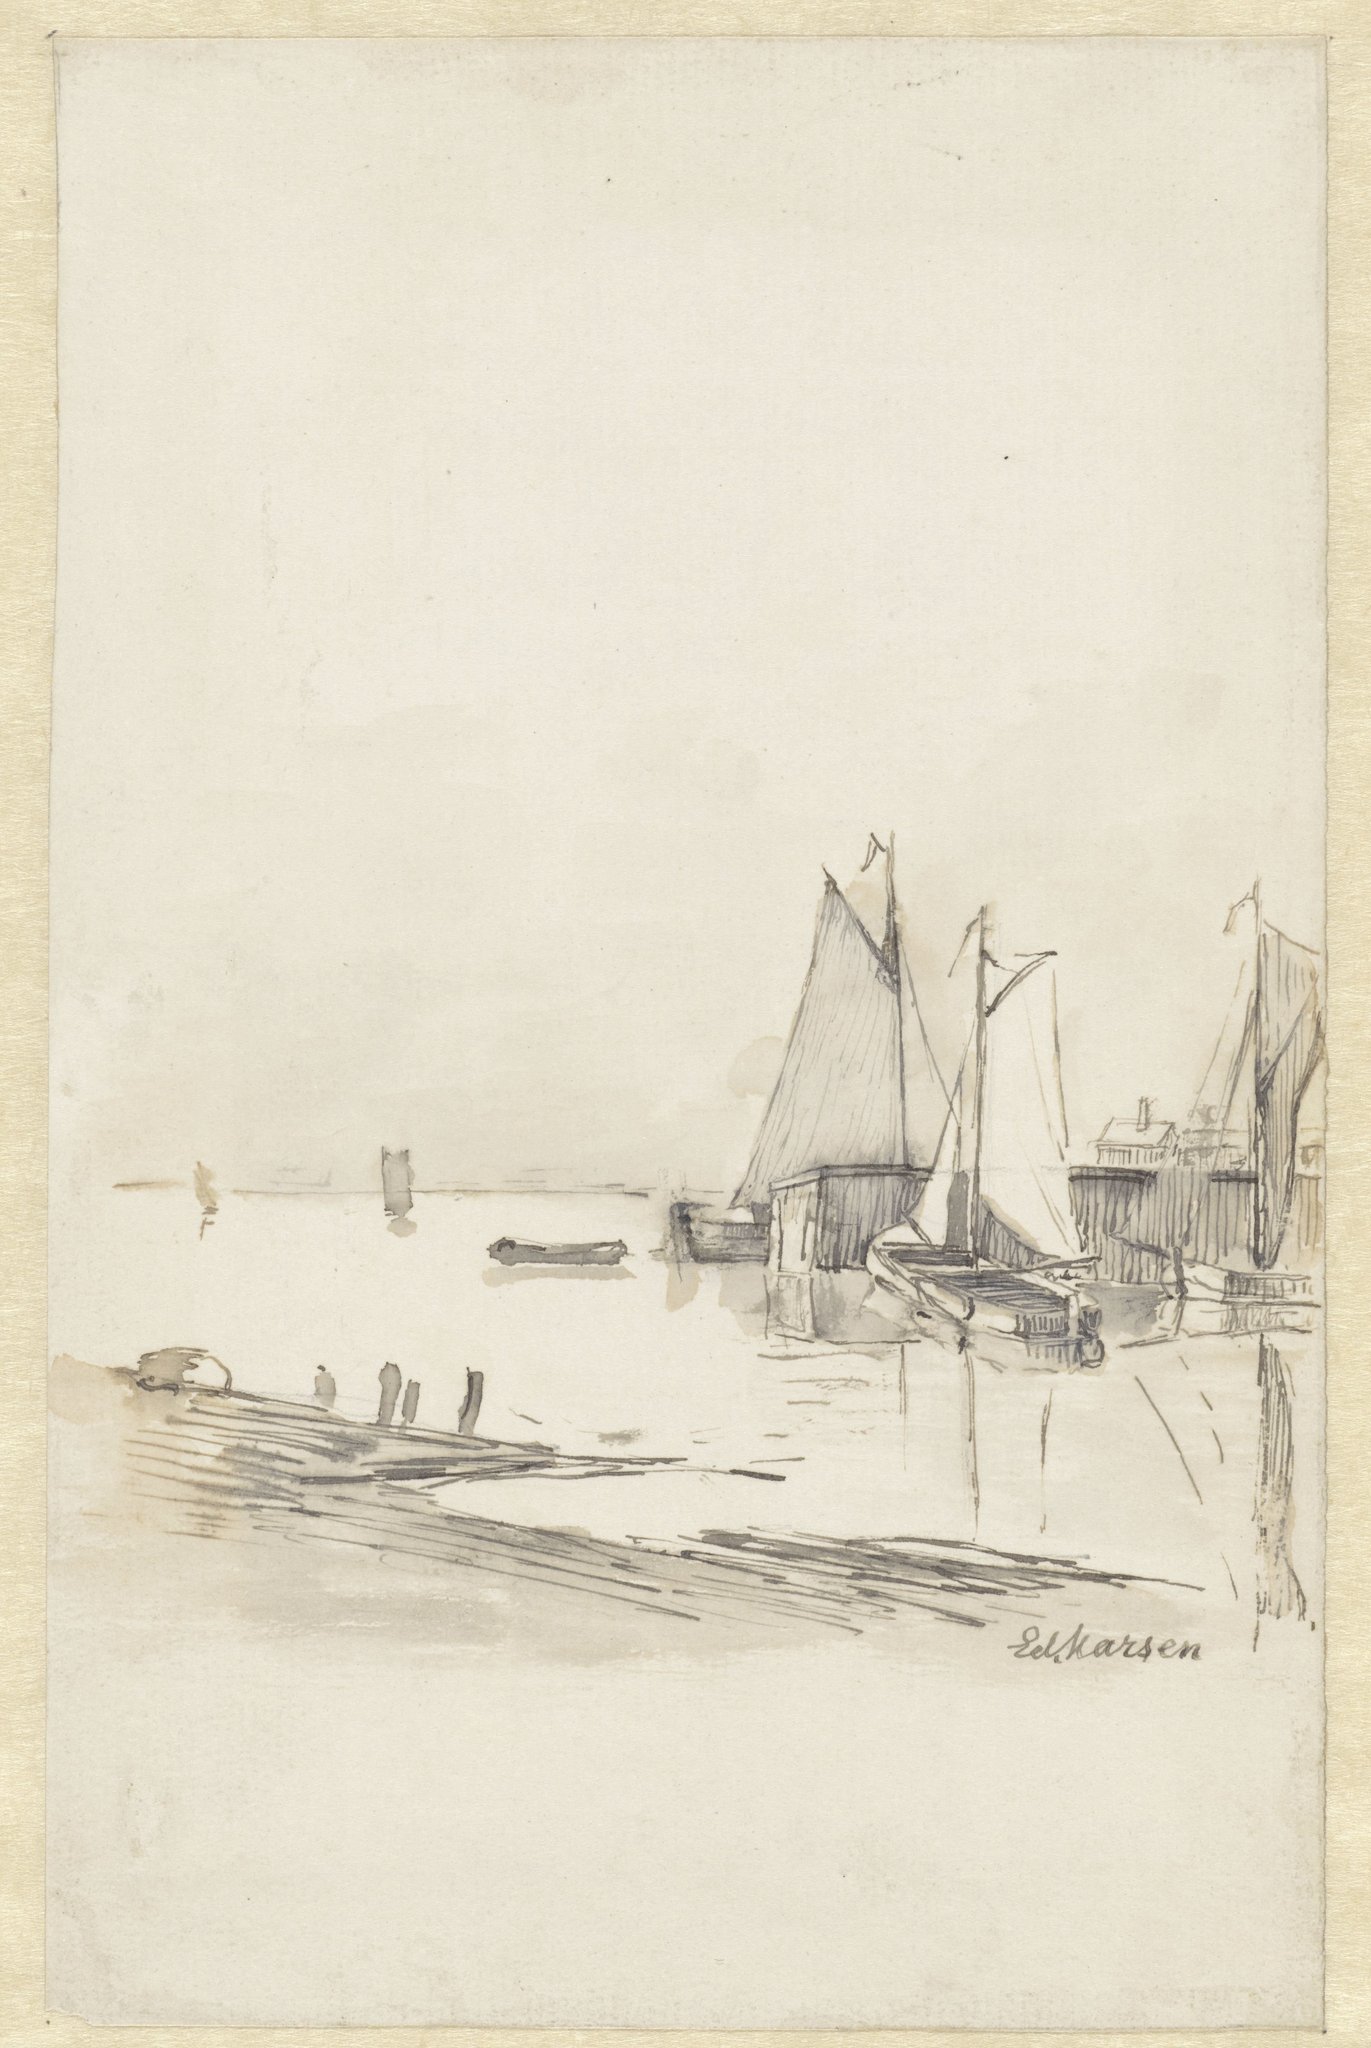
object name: drawing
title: Haventje met boten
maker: eduard karsen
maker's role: draughtsman, painter, print maker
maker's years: 1860-1941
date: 1870-1922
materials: ink, paper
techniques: brush, pen